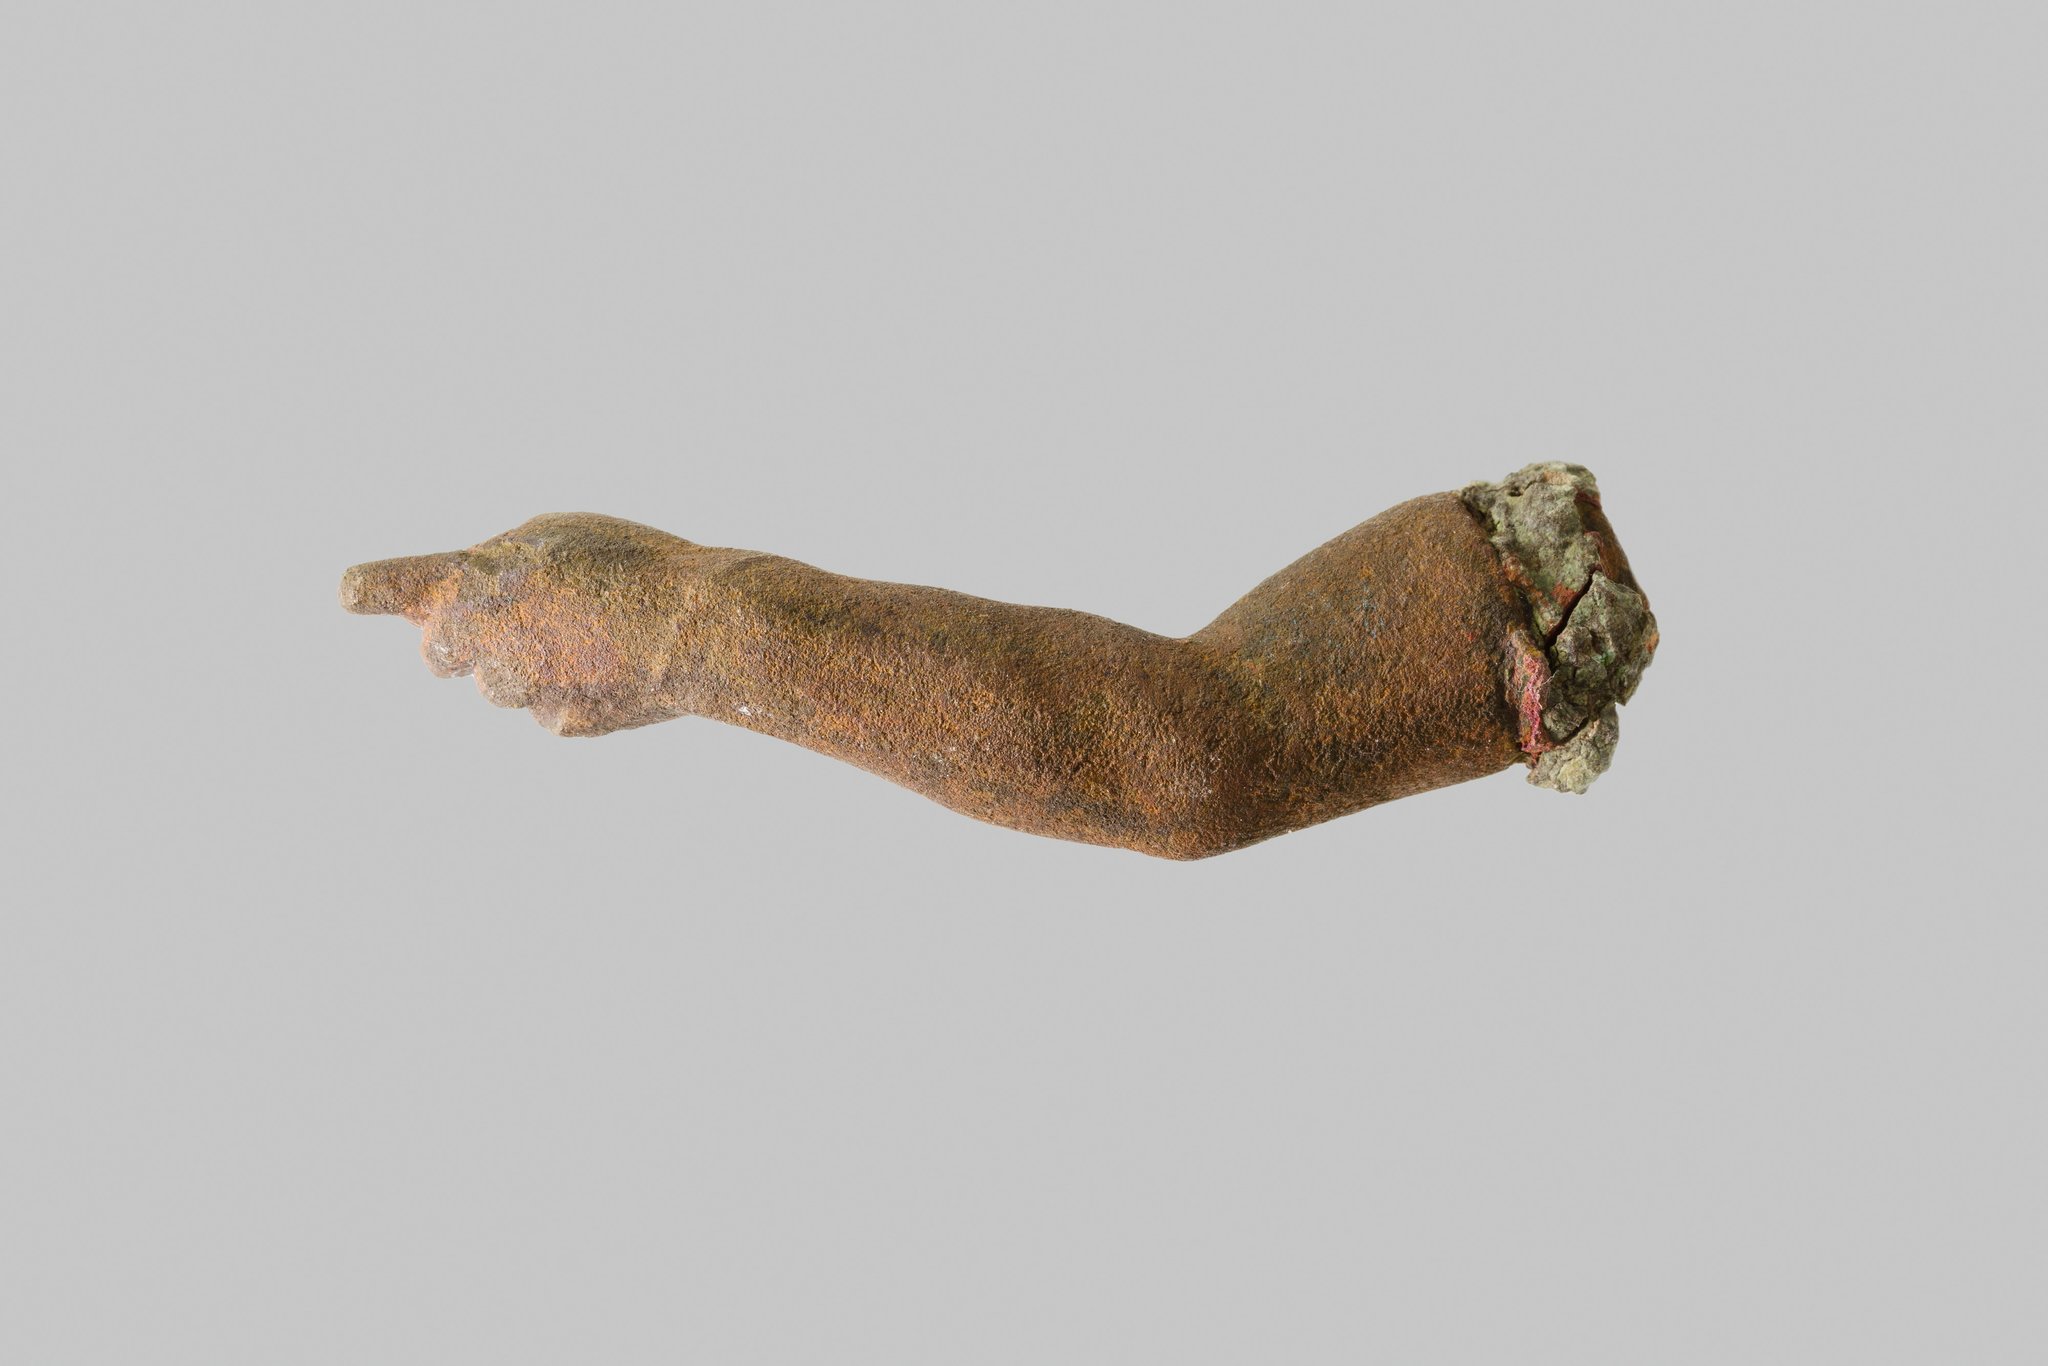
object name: statuette, arm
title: Hellenistic-style arm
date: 712-30 BCE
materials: bronze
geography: egypt